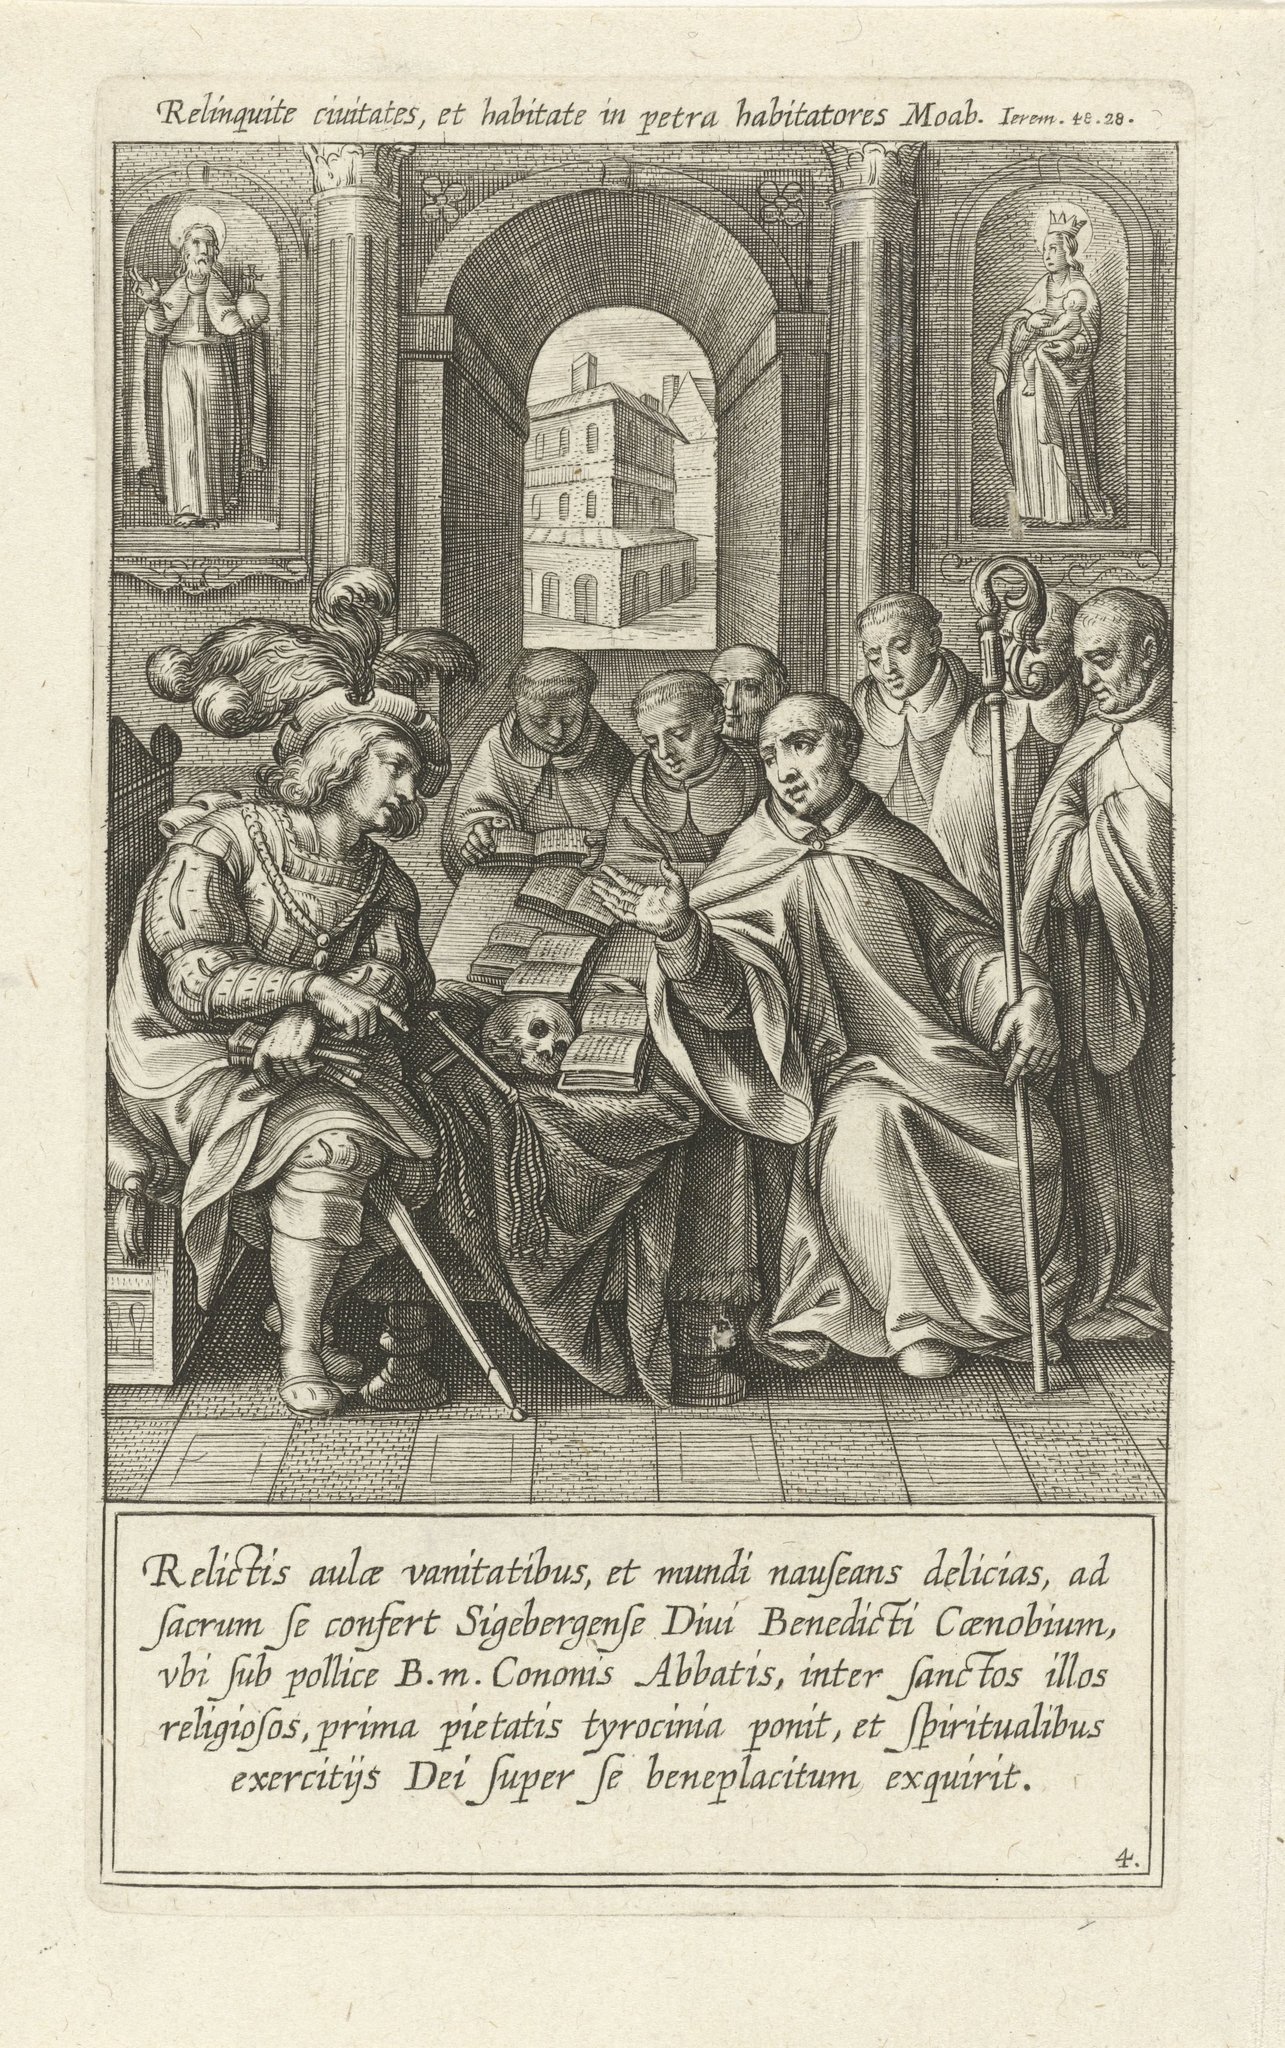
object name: book illustration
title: Conversatie tussen de heilige Norbertus en abt Connon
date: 1622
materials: paper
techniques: engraving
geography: antwerp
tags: personal devotion of st. norbert - baptism, consecration, taking vows of male saint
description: De heilige Norbertus trekt naar het benedictijnenklooster van Siegburg en praat daar met abt Connon. De prent heeft twee Latijnse opschriften: een boven en een onder de voorstelling.